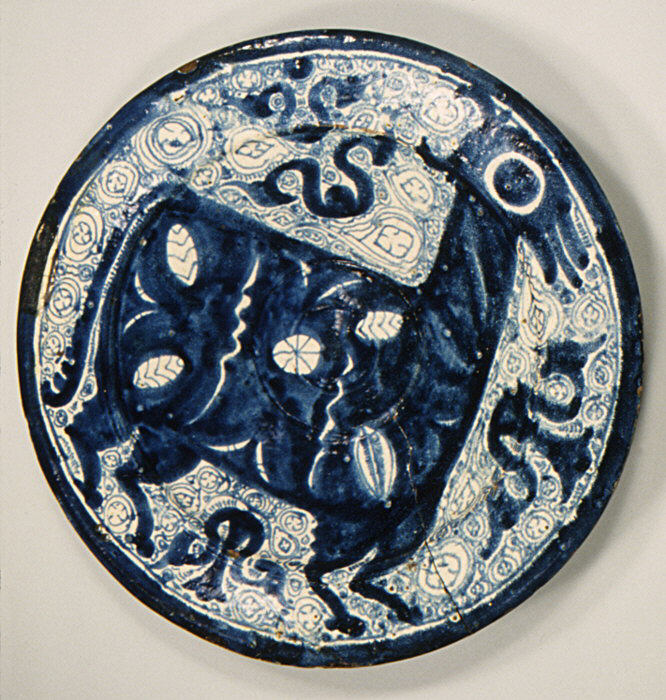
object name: plate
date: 1501-1600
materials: earthenware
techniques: glazing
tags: animals